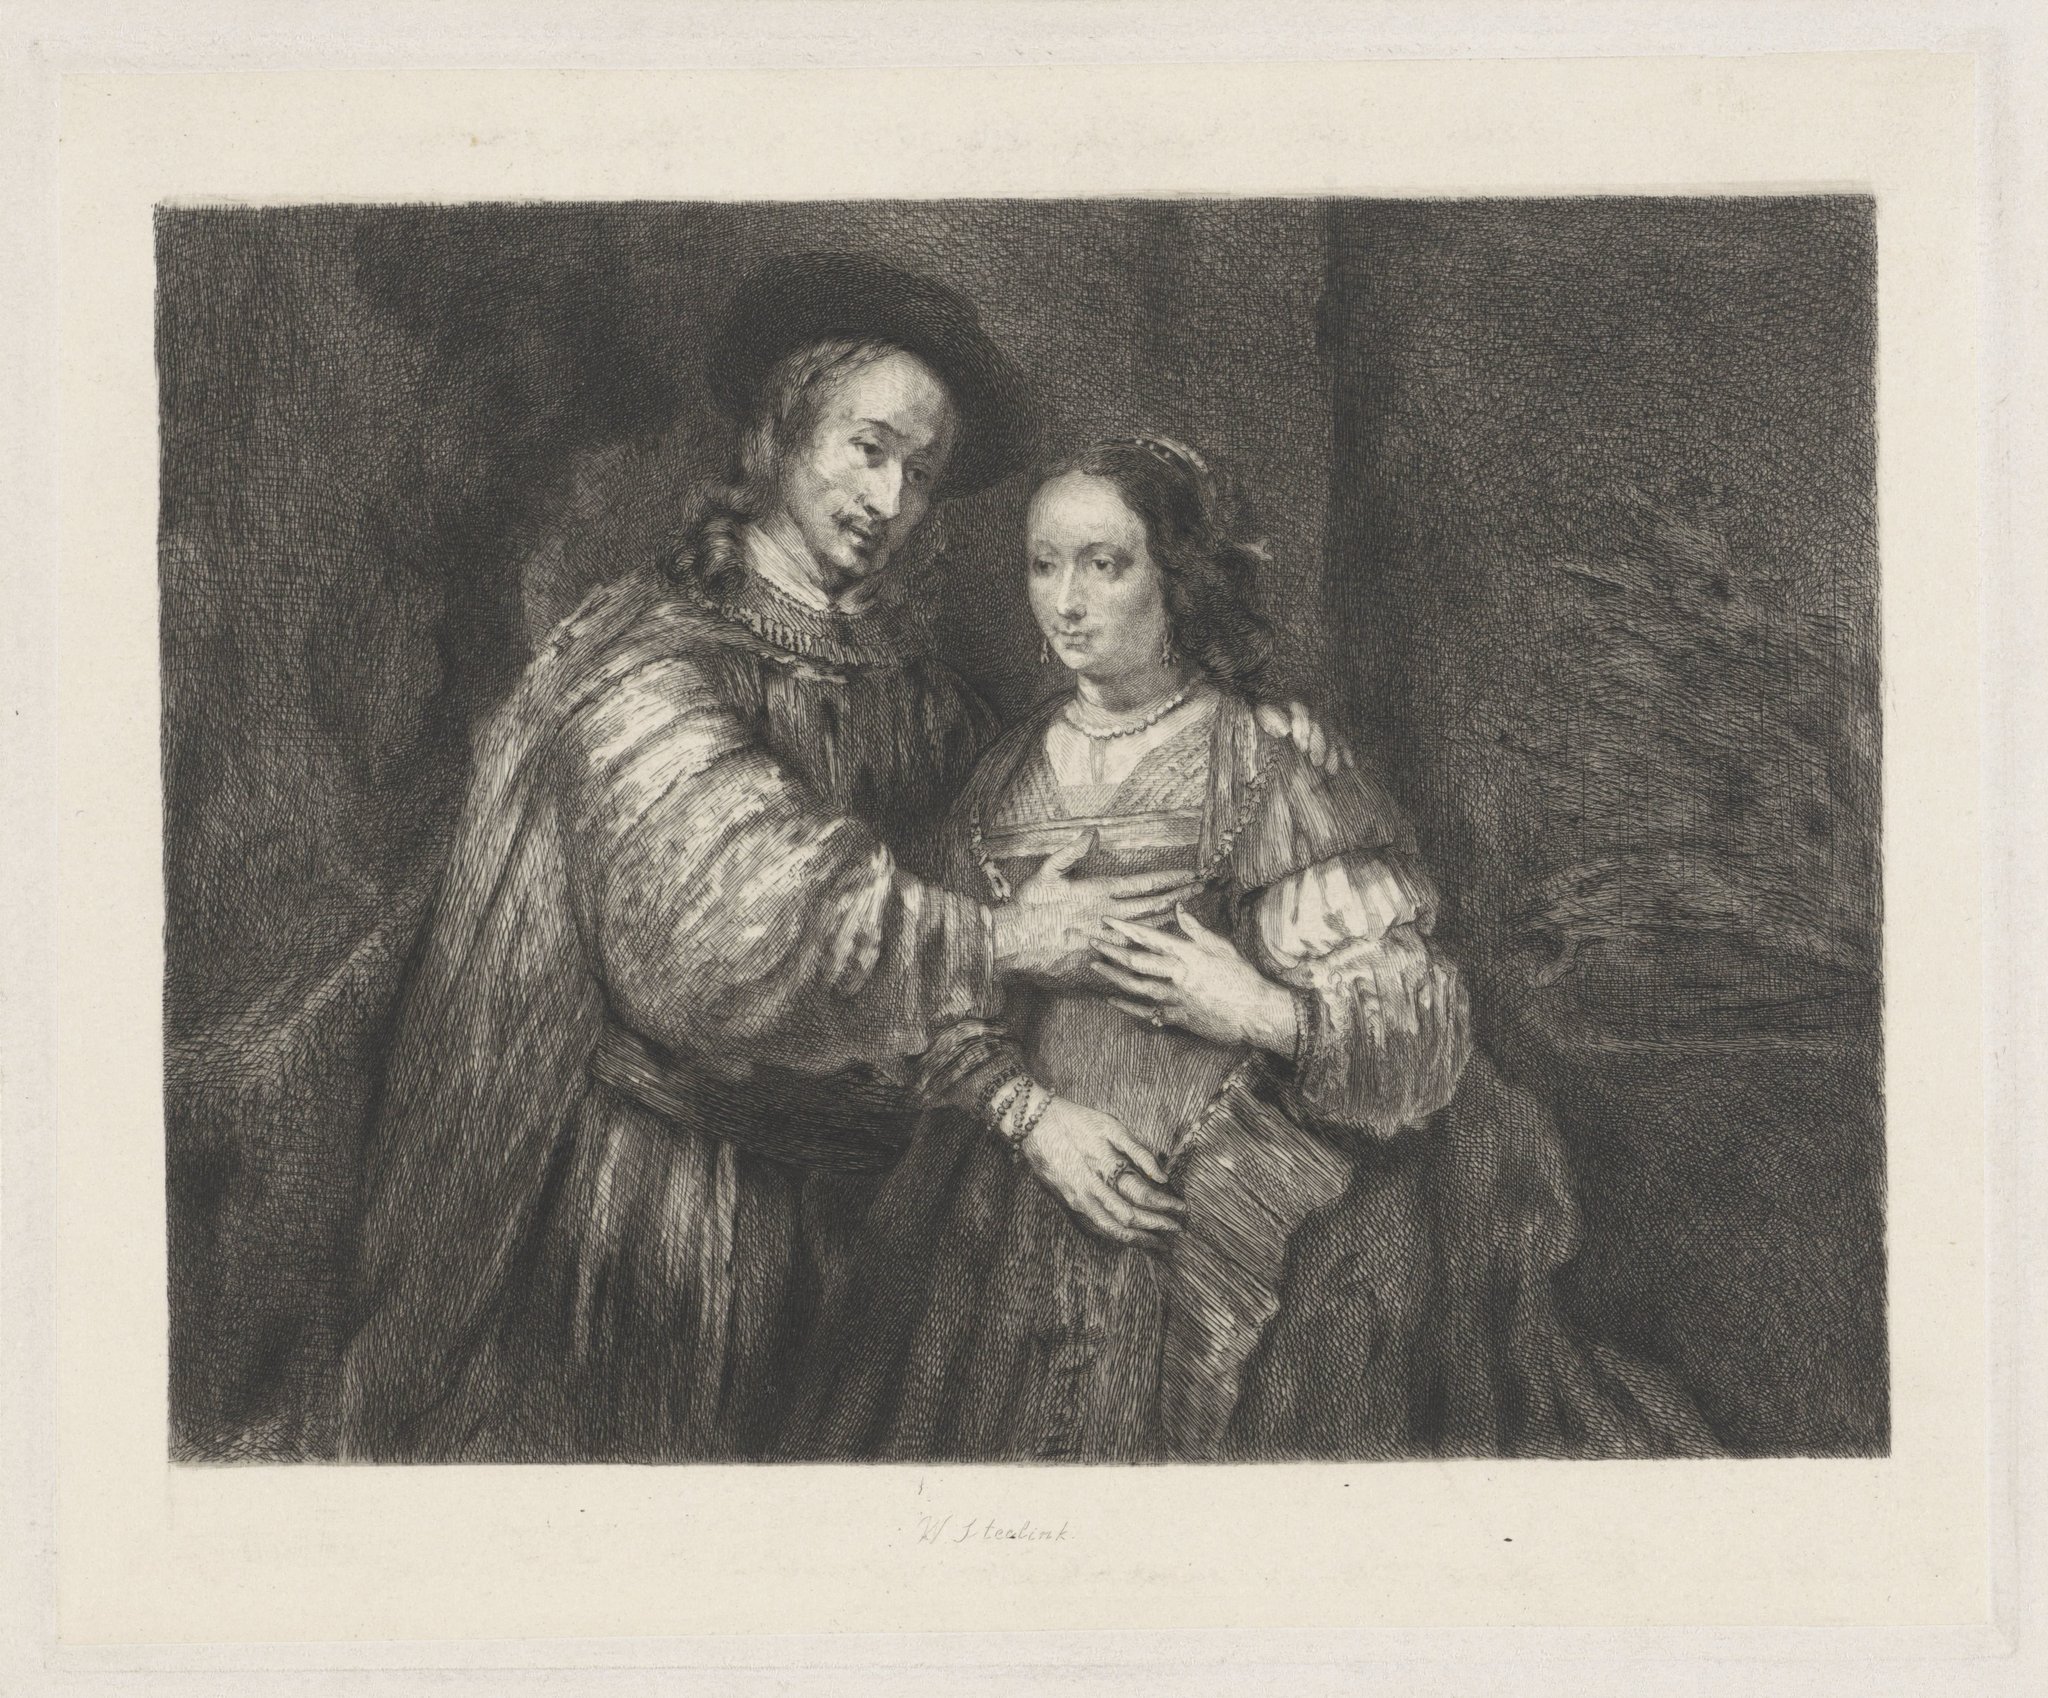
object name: print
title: Portret van een paar als Oud-Testamentische figuren, genaamd 'Het Joodse bruidje'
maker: willem steelink (i)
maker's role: draughtsman, print maker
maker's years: 1826-1913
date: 1866-1890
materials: paper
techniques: engraving, etching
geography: netherlands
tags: marriage, married couple, 'matrimonium', marriage of isaac and rebekah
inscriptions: collector's mark: Lugt 2228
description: Portret van een paar als Isaak en Rebekka of andere Oud-Testamentische figuren, bekend onder de titel 'Het Joodse bruidje' of 'De Joodse bruid'. De man legt zijn rechterhand op de borst van de vrouw, de linkerarm over de schouders. De vrouw legt haar linkerhand op de hand van de man, de rechterhand voor de buik.